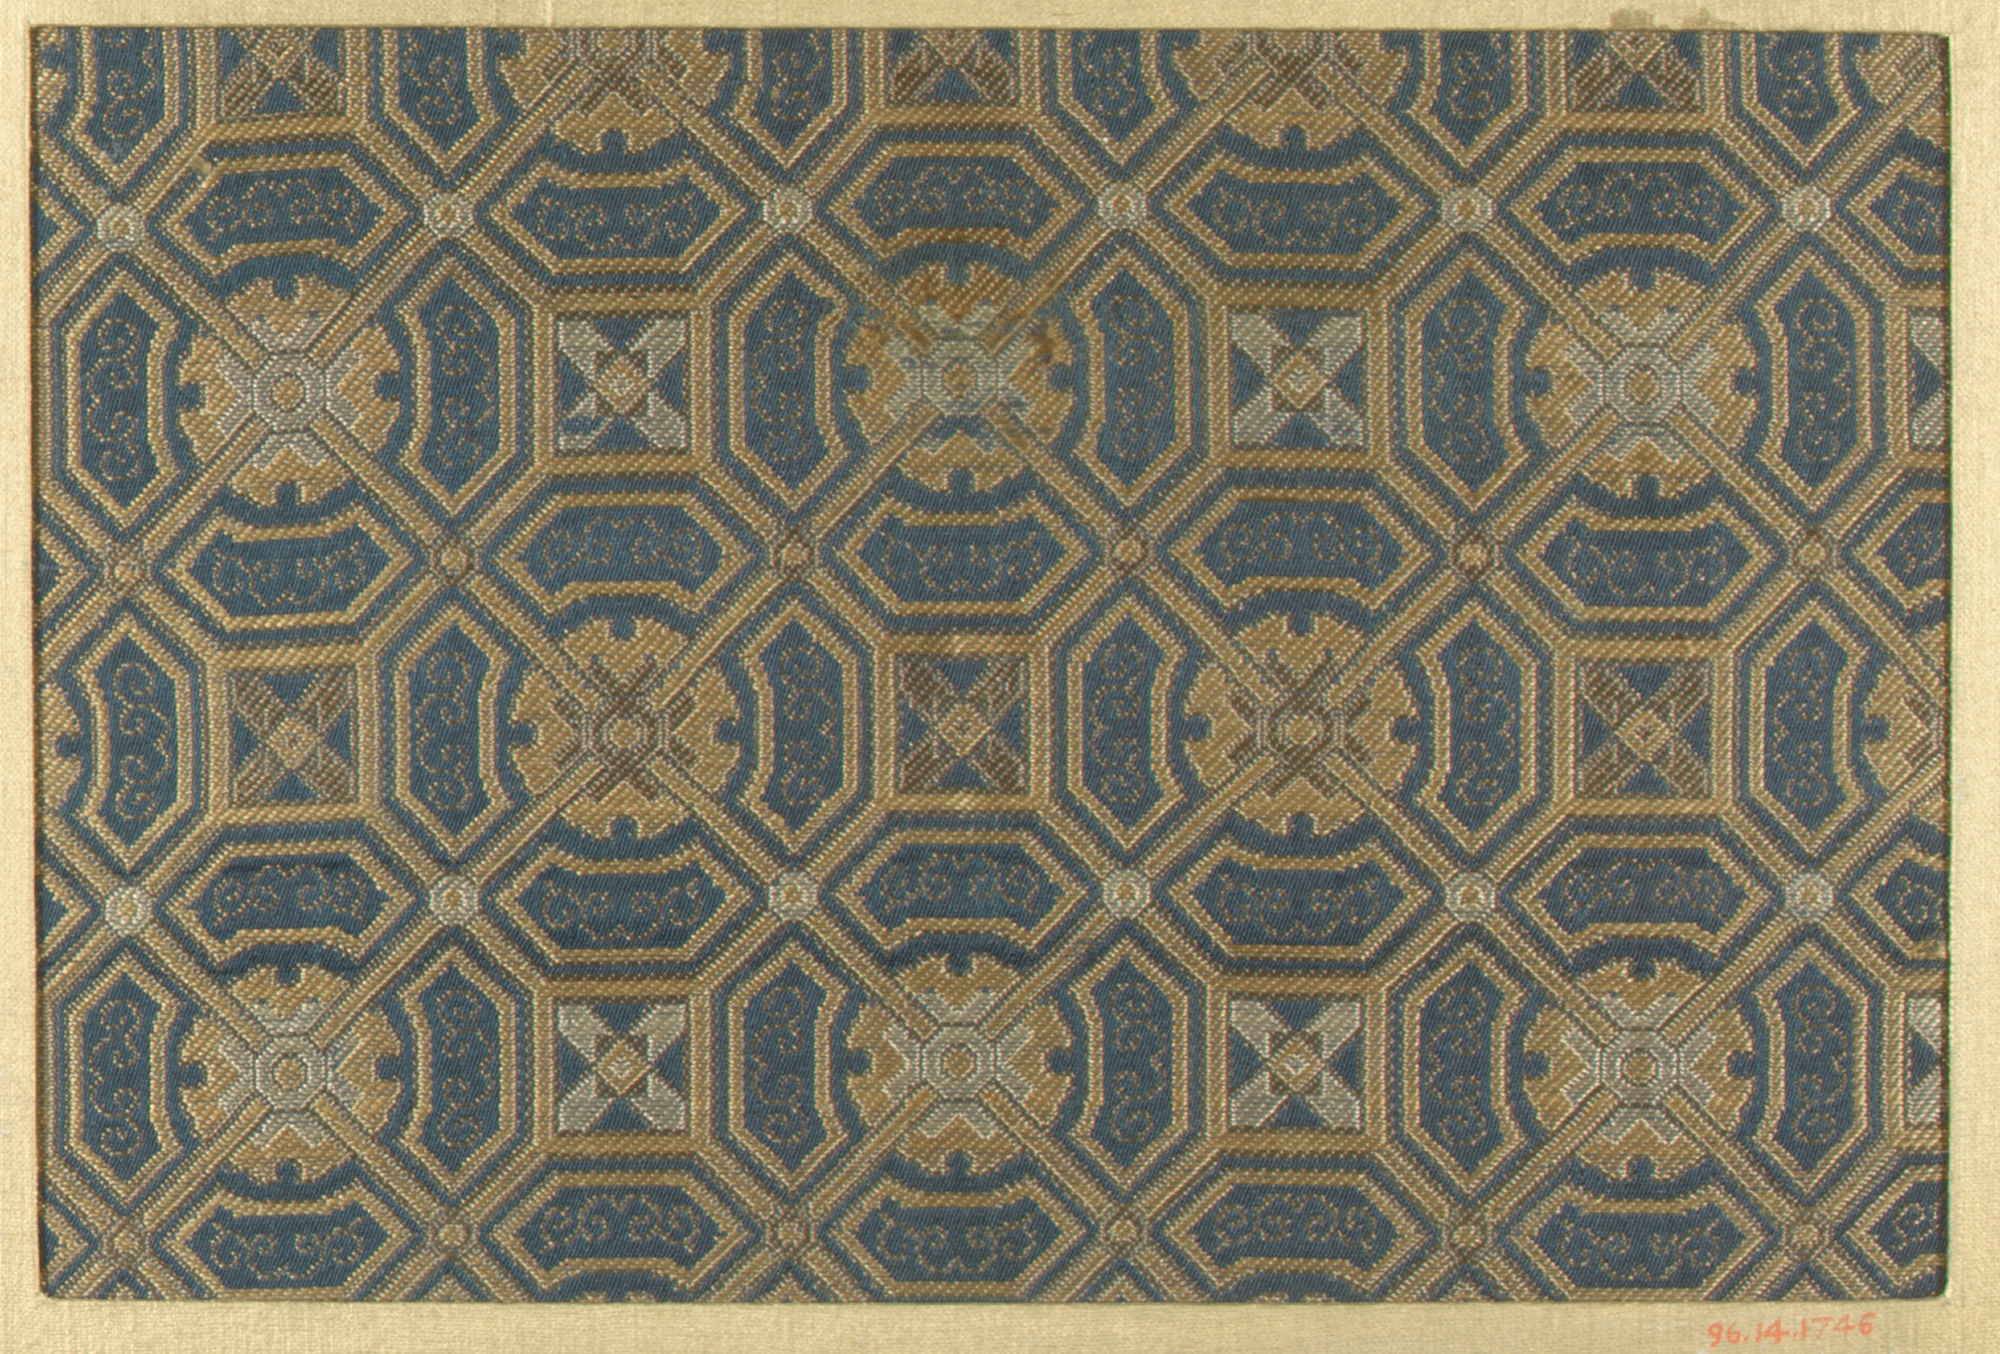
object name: piece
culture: japanese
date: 1701-1900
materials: silk